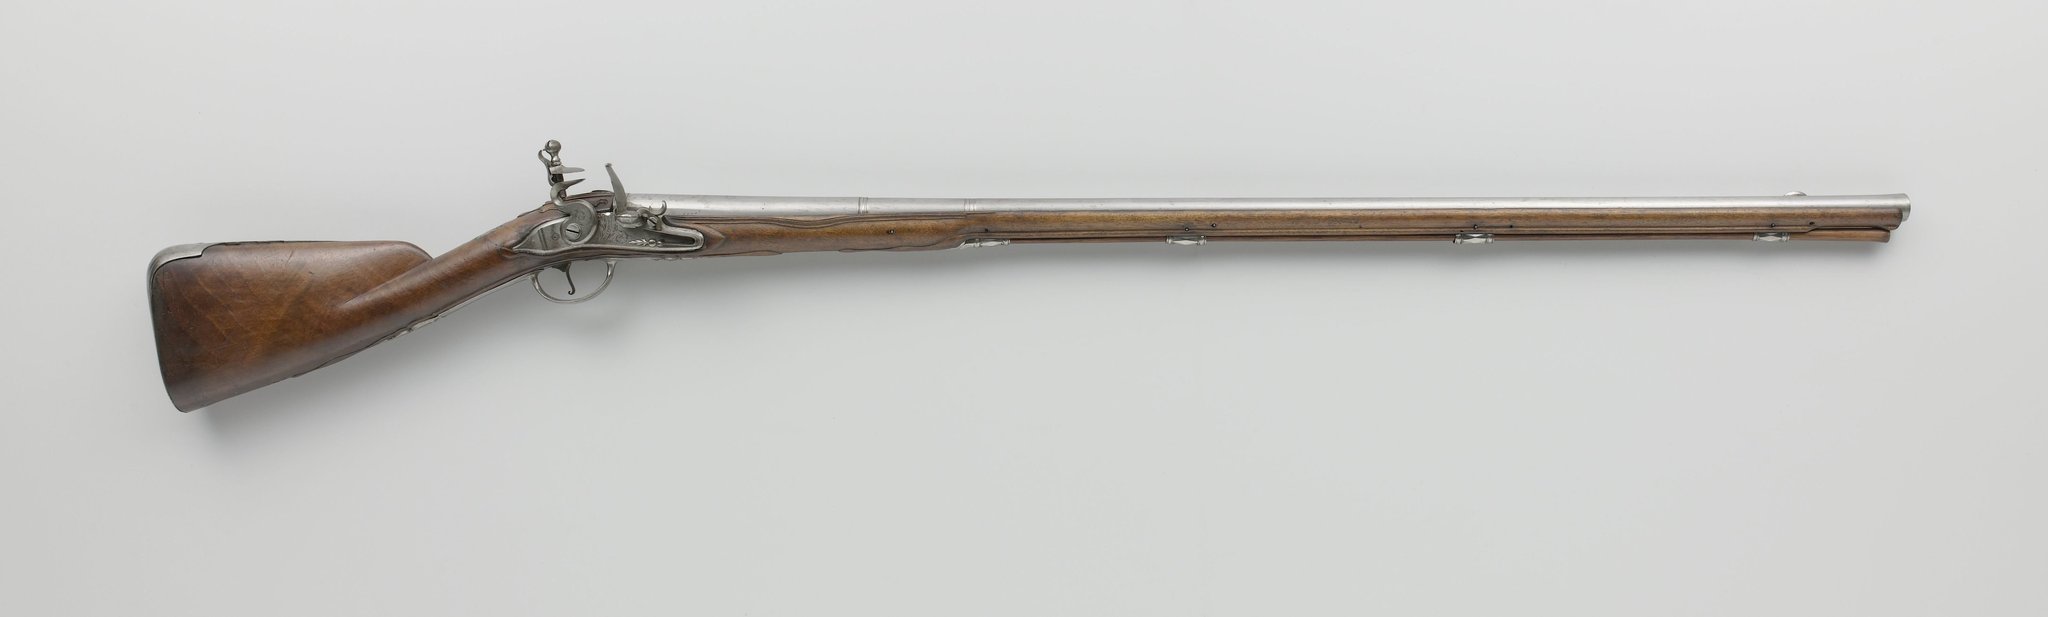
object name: flintlock pistol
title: Vuursteenjachtgeweer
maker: jan krans jr.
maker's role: geweermaker, pistoolmaker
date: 1710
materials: iron, wood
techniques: printing, engraving, striking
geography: maastricht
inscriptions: signature: ‘IEAN KRANS en A MASTRICHT’, signature: ‘IEAN // KRANSAMAS // TRICHT’, mark, mark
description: Het slot is gegraveerd met lofwerk en een signatuur. De loop heeft een wijder wordende tromp voorzien van een ijzeren vizierkorrel en is gegraveerd met een signatuur in een banderol en onderop een onduidelijk merk. De walnotenhouten kolf heeft eenvoudig snijwerk en is gebrandmerkt met twee vissen boven een gestempeld cijfer 11. Het ijzeren beslag bestaat onder meer uit vier laadstokkokers, een gebeitelde schroefplaat in de vorm van twee ranken aan weerszijden van een masker, een onversierde duimplaat uitlopend in een acanthusblad, een langgerekte kolfplaat en de houten laadstok.